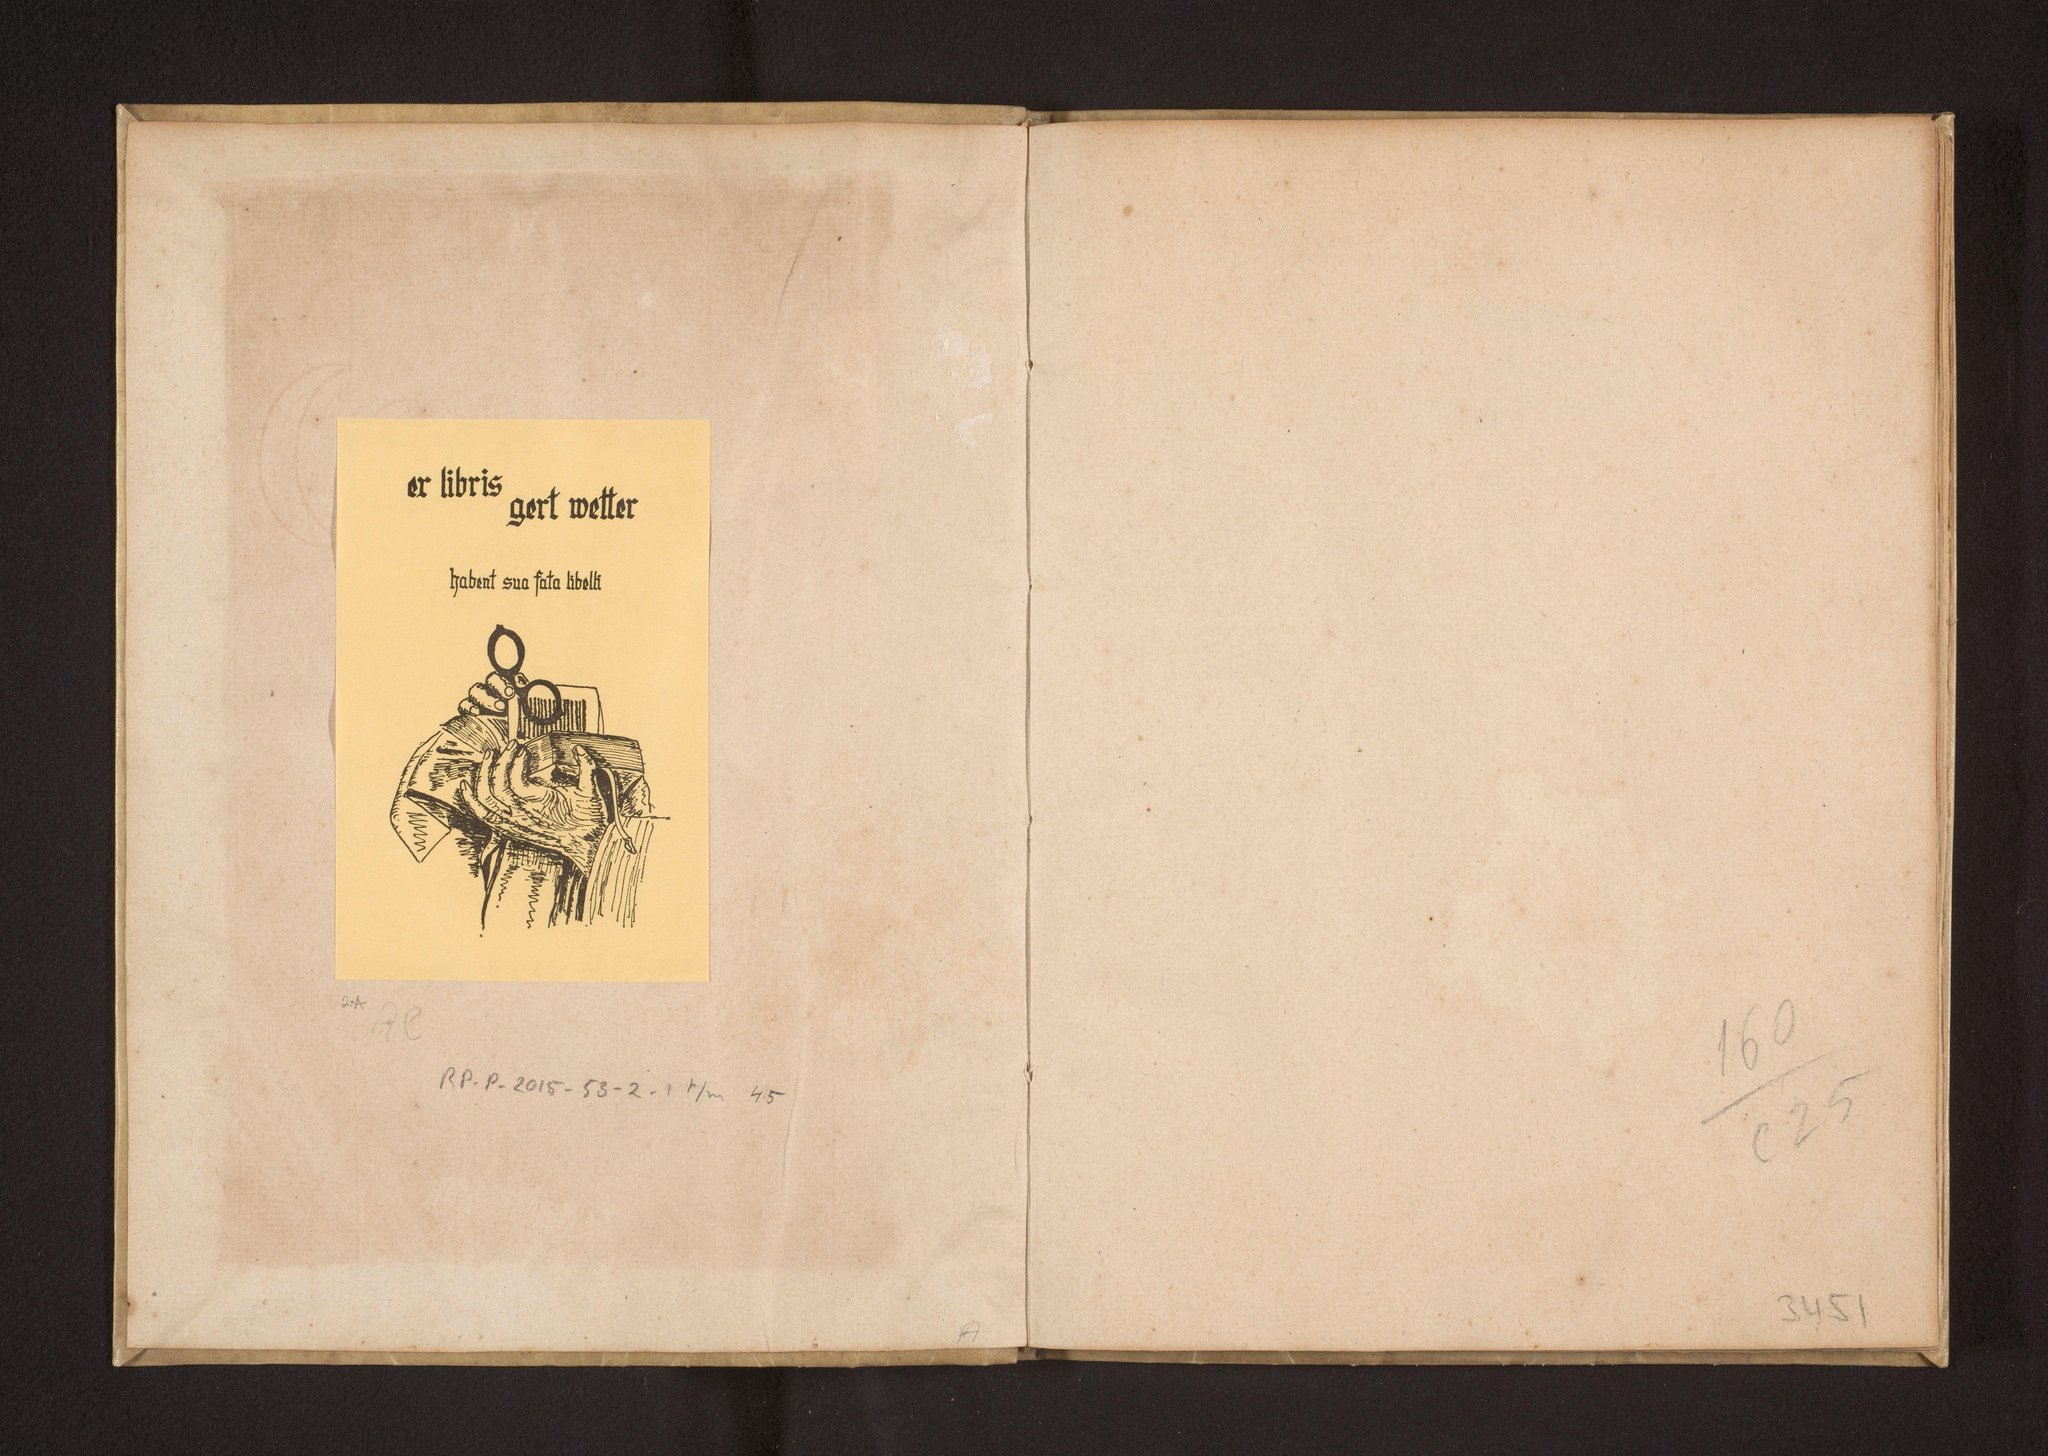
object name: bookplate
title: Ex libris van Gert Wetter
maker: Anonymous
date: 1880-1950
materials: paper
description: Ex libris van Gert Wetter, geplakt op de binnenzijde van de voorzijde van de band met een reeks van 44 prenten met scènes uit het leven van Filippo Neri.